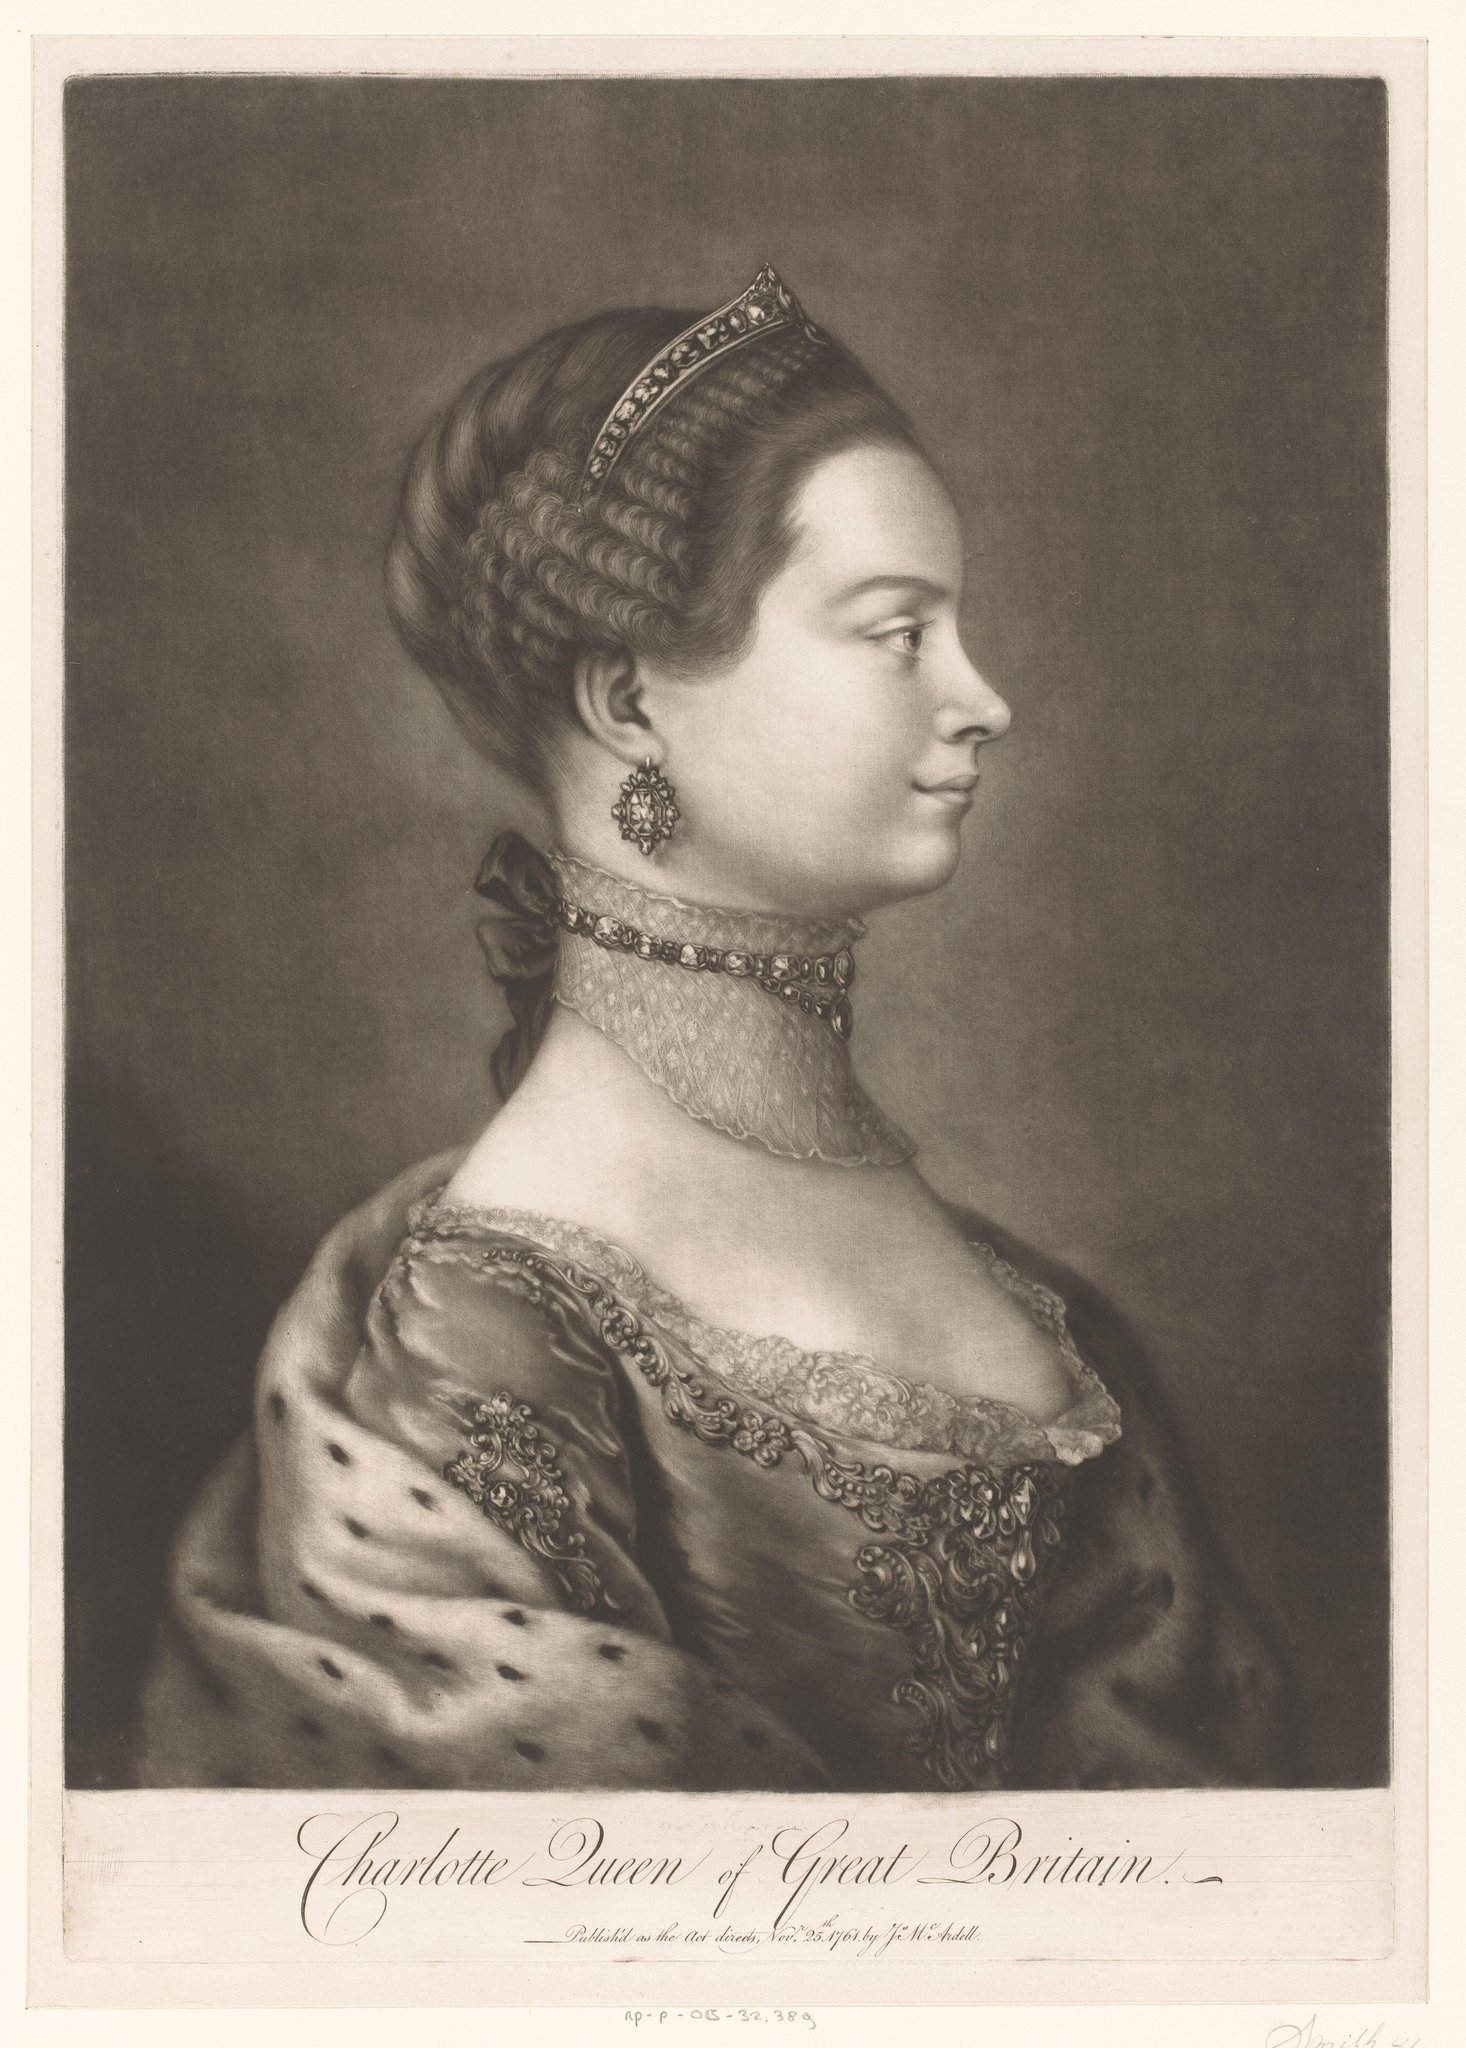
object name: print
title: Portret van Charlotte van Mecklenburg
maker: james mcardell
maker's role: print maker, publisher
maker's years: 1728-1765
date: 1711-1761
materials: paper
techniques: mezzotint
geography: london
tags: london, charlotte van mecklenburg (koningin van groot-brittannië en ierland), historical persons - bb - woman, queen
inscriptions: date